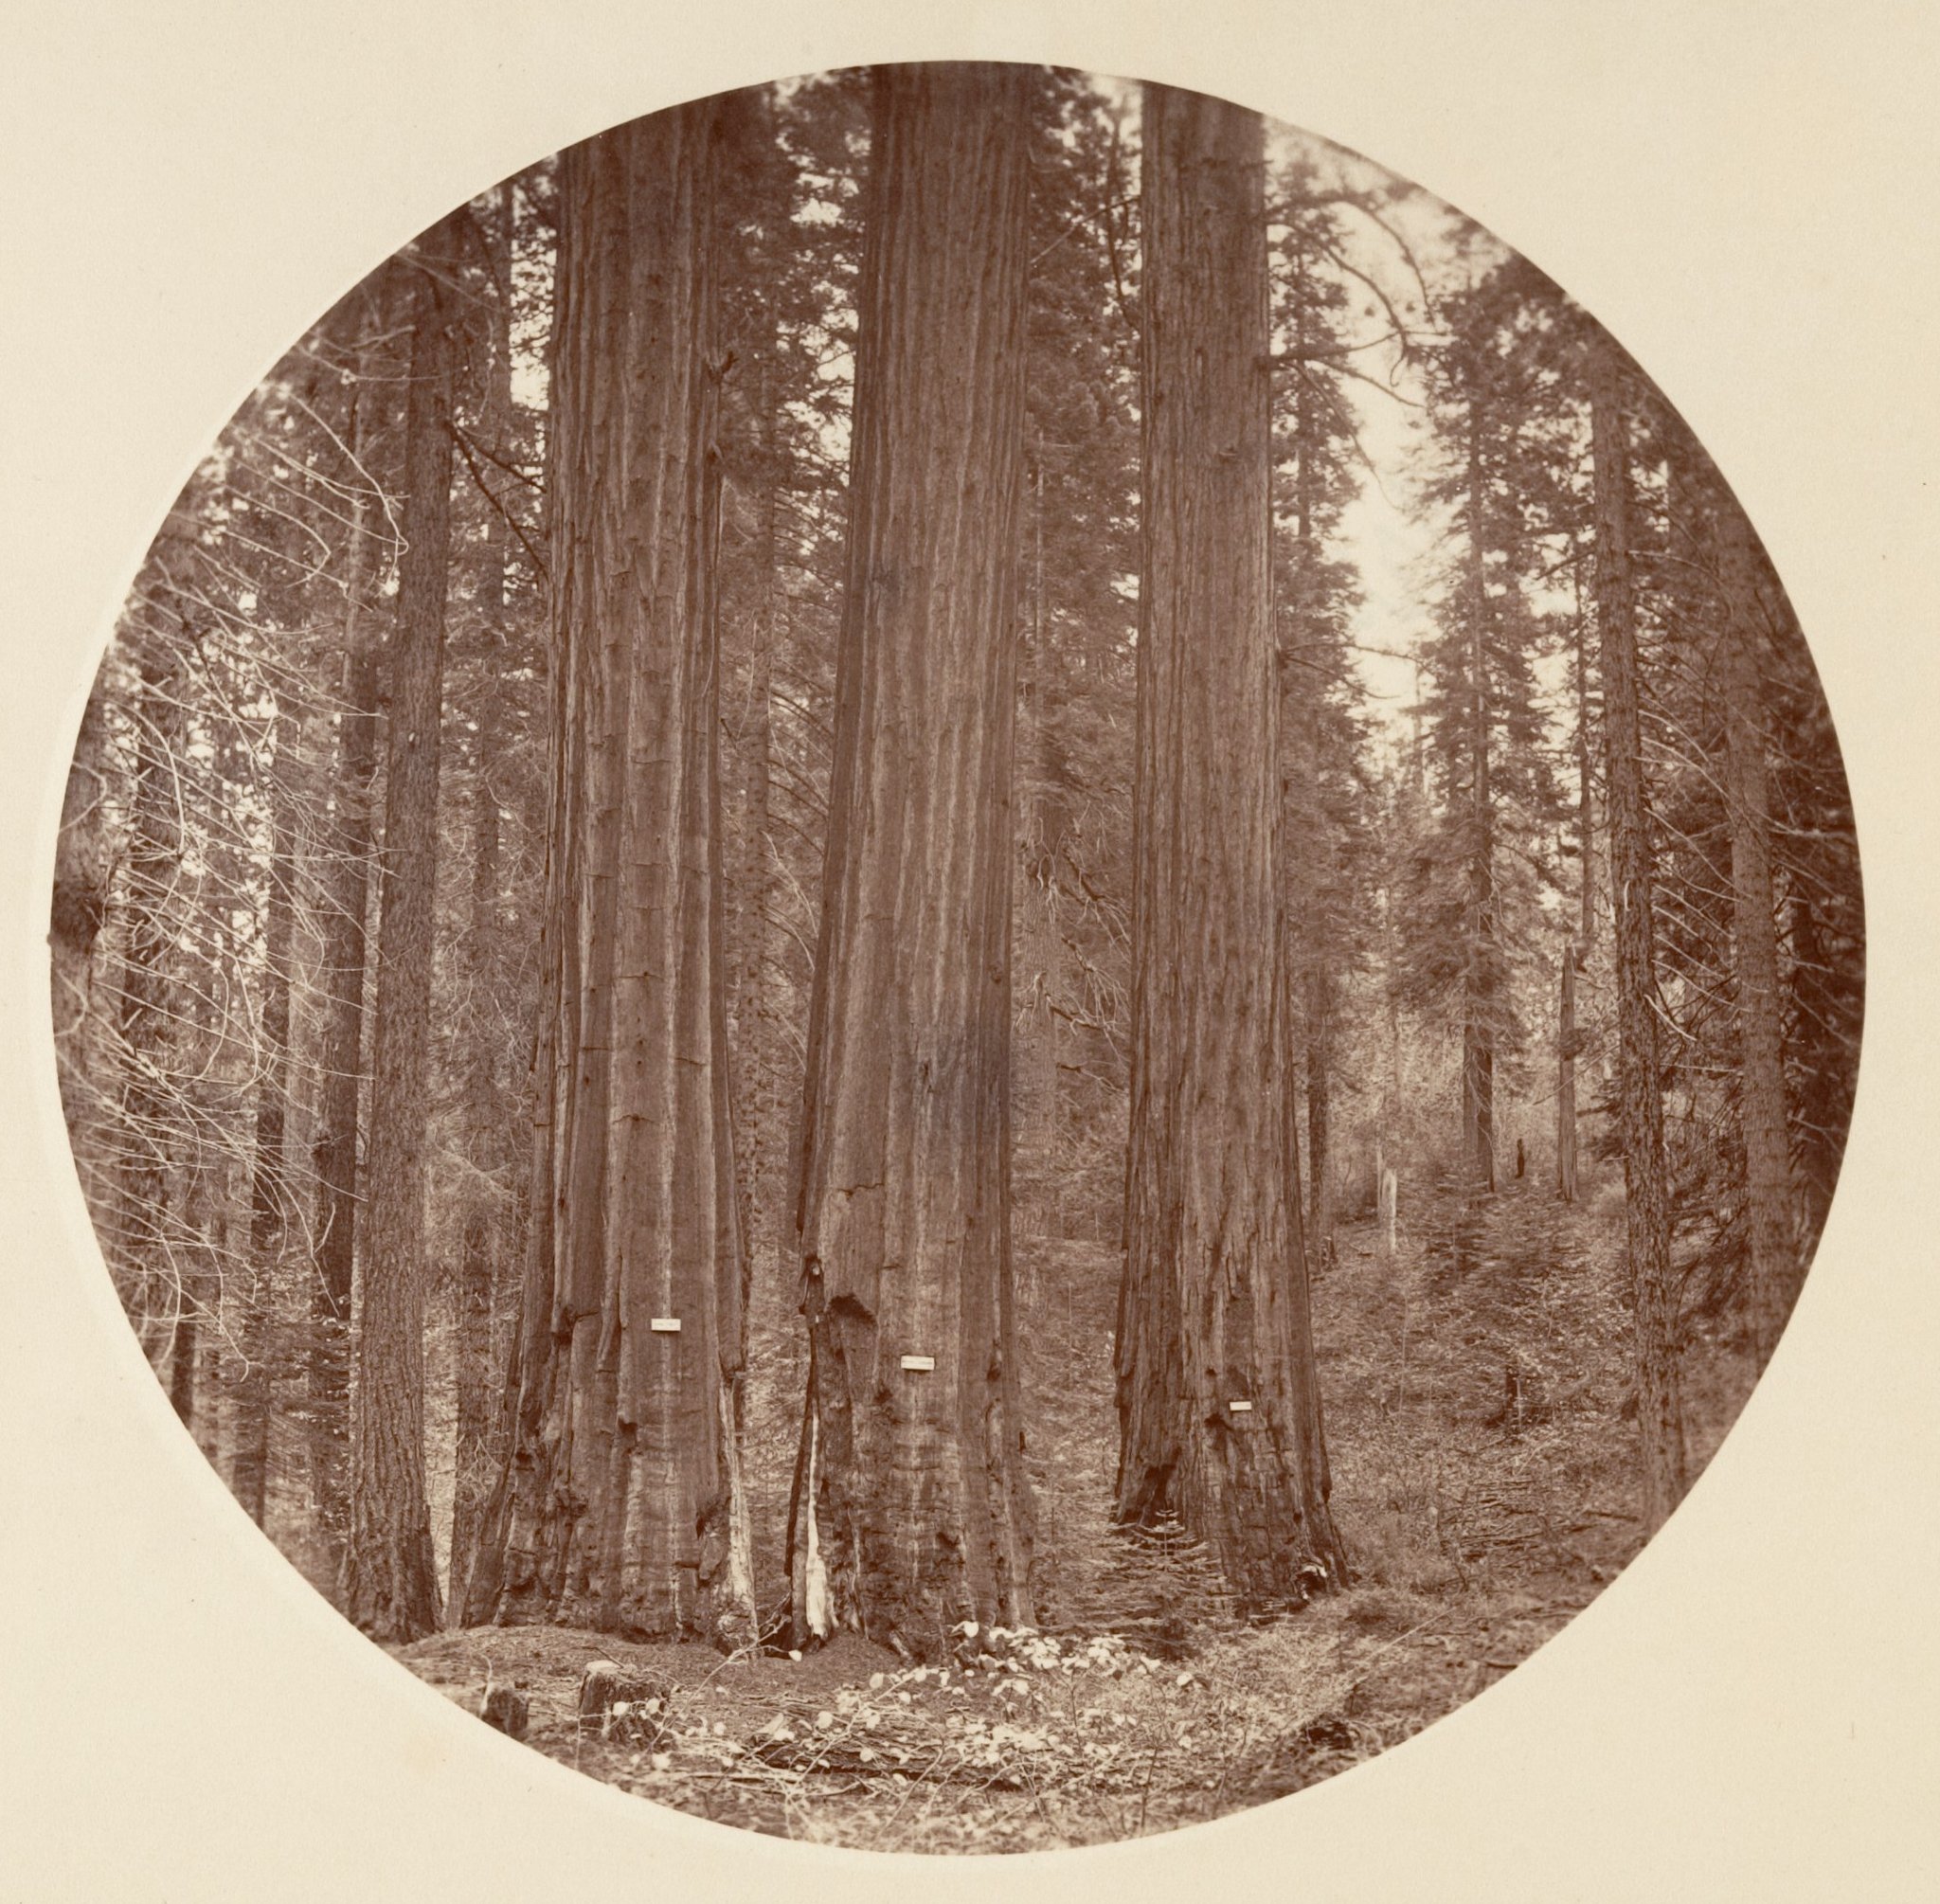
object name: photograph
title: [Yosemite National Park, California]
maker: carleton e. watkins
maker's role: artist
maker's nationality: american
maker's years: 1829-1916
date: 1878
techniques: albumen silver print, glass negative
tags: forests,trees